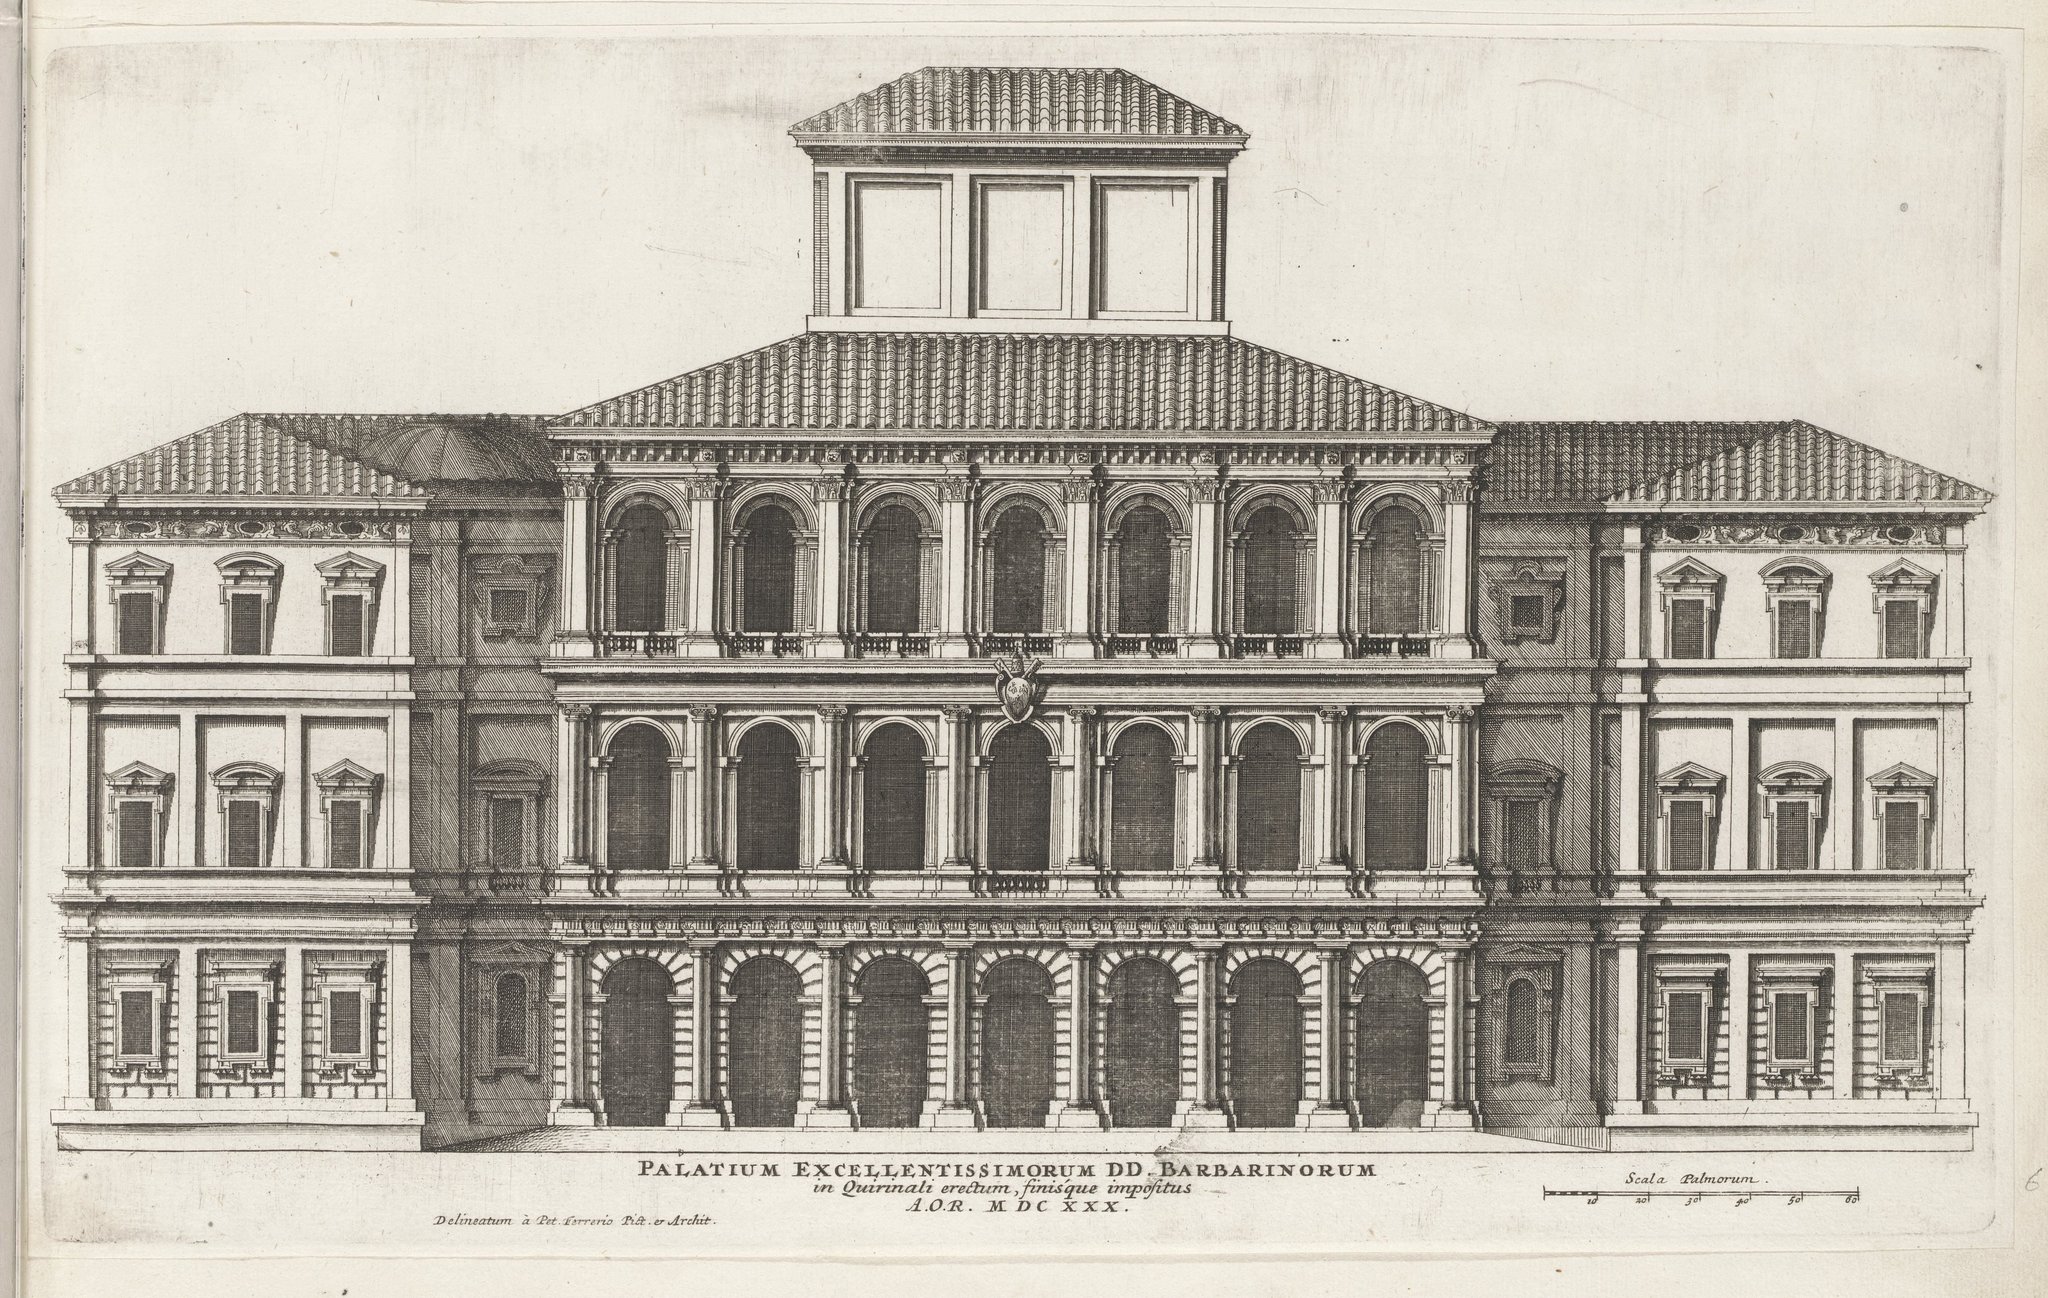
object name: album leaf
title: Façade van Palazzo Barberini te Rome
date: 1655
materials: paper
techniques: etching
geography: italy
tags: palace, façade (of house or building)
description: Deze prent maakt deel uit van de reeks getiteld: Palazzi di Roma. Deze reeks bestaat uit twee boeken. Boek één getiteld: Palazzi di Roma dei più celebri architetti..., bestaat uit 44 prenten die worden toegeschreven aan Giovanni Battista Falda (naam staat enkel op prent 27) en uitgegeven door Giovanni Giacomo de'Rossi. Deze 44 prenten zijn bekend in twee staten (met en zonder nummer). Boek twee getiteld: Nuovi disegni dell'architetture... libro secondo, bevat 66 prenten door Giovanni Battista Falda en Simone Felice. Deze 66 prenten zijn bekend in twee staten (met en zonder nummer).